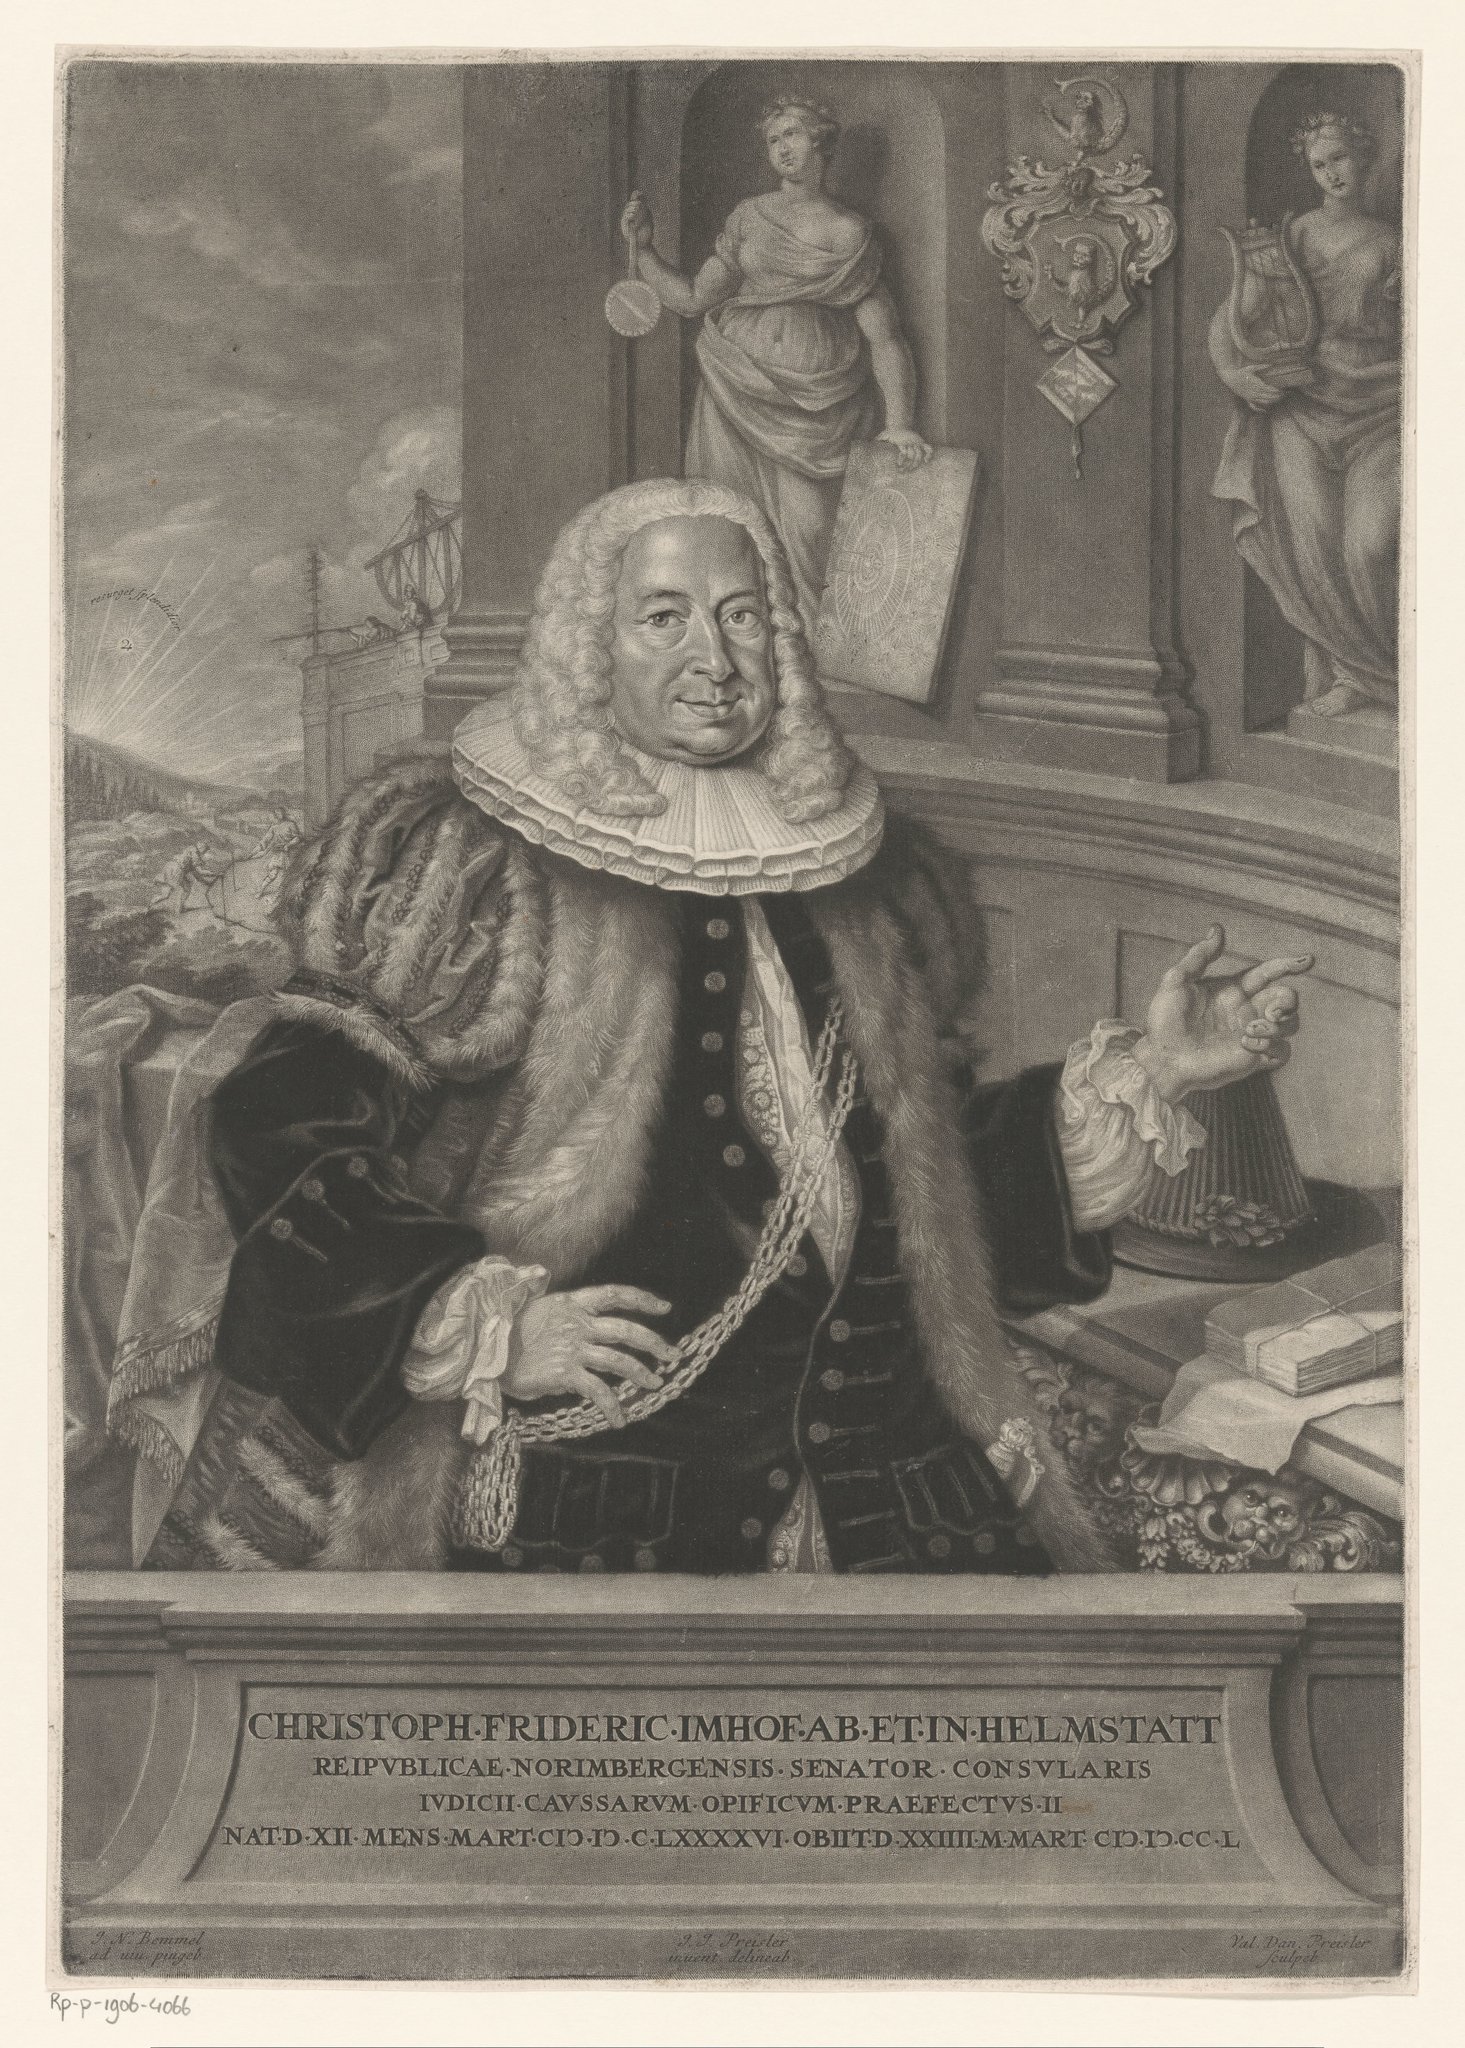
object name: print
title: Portret van Christoph Friedrich Imhof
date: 1750-1765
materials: paper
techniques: mezzotint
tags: observatory (~ astronomy), historical persons, abstract ideas and concepts (+ emblematical representation of concept), single muses, beasts of prey, predatory animals: lion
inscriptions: collector's mark: Lugt 2228